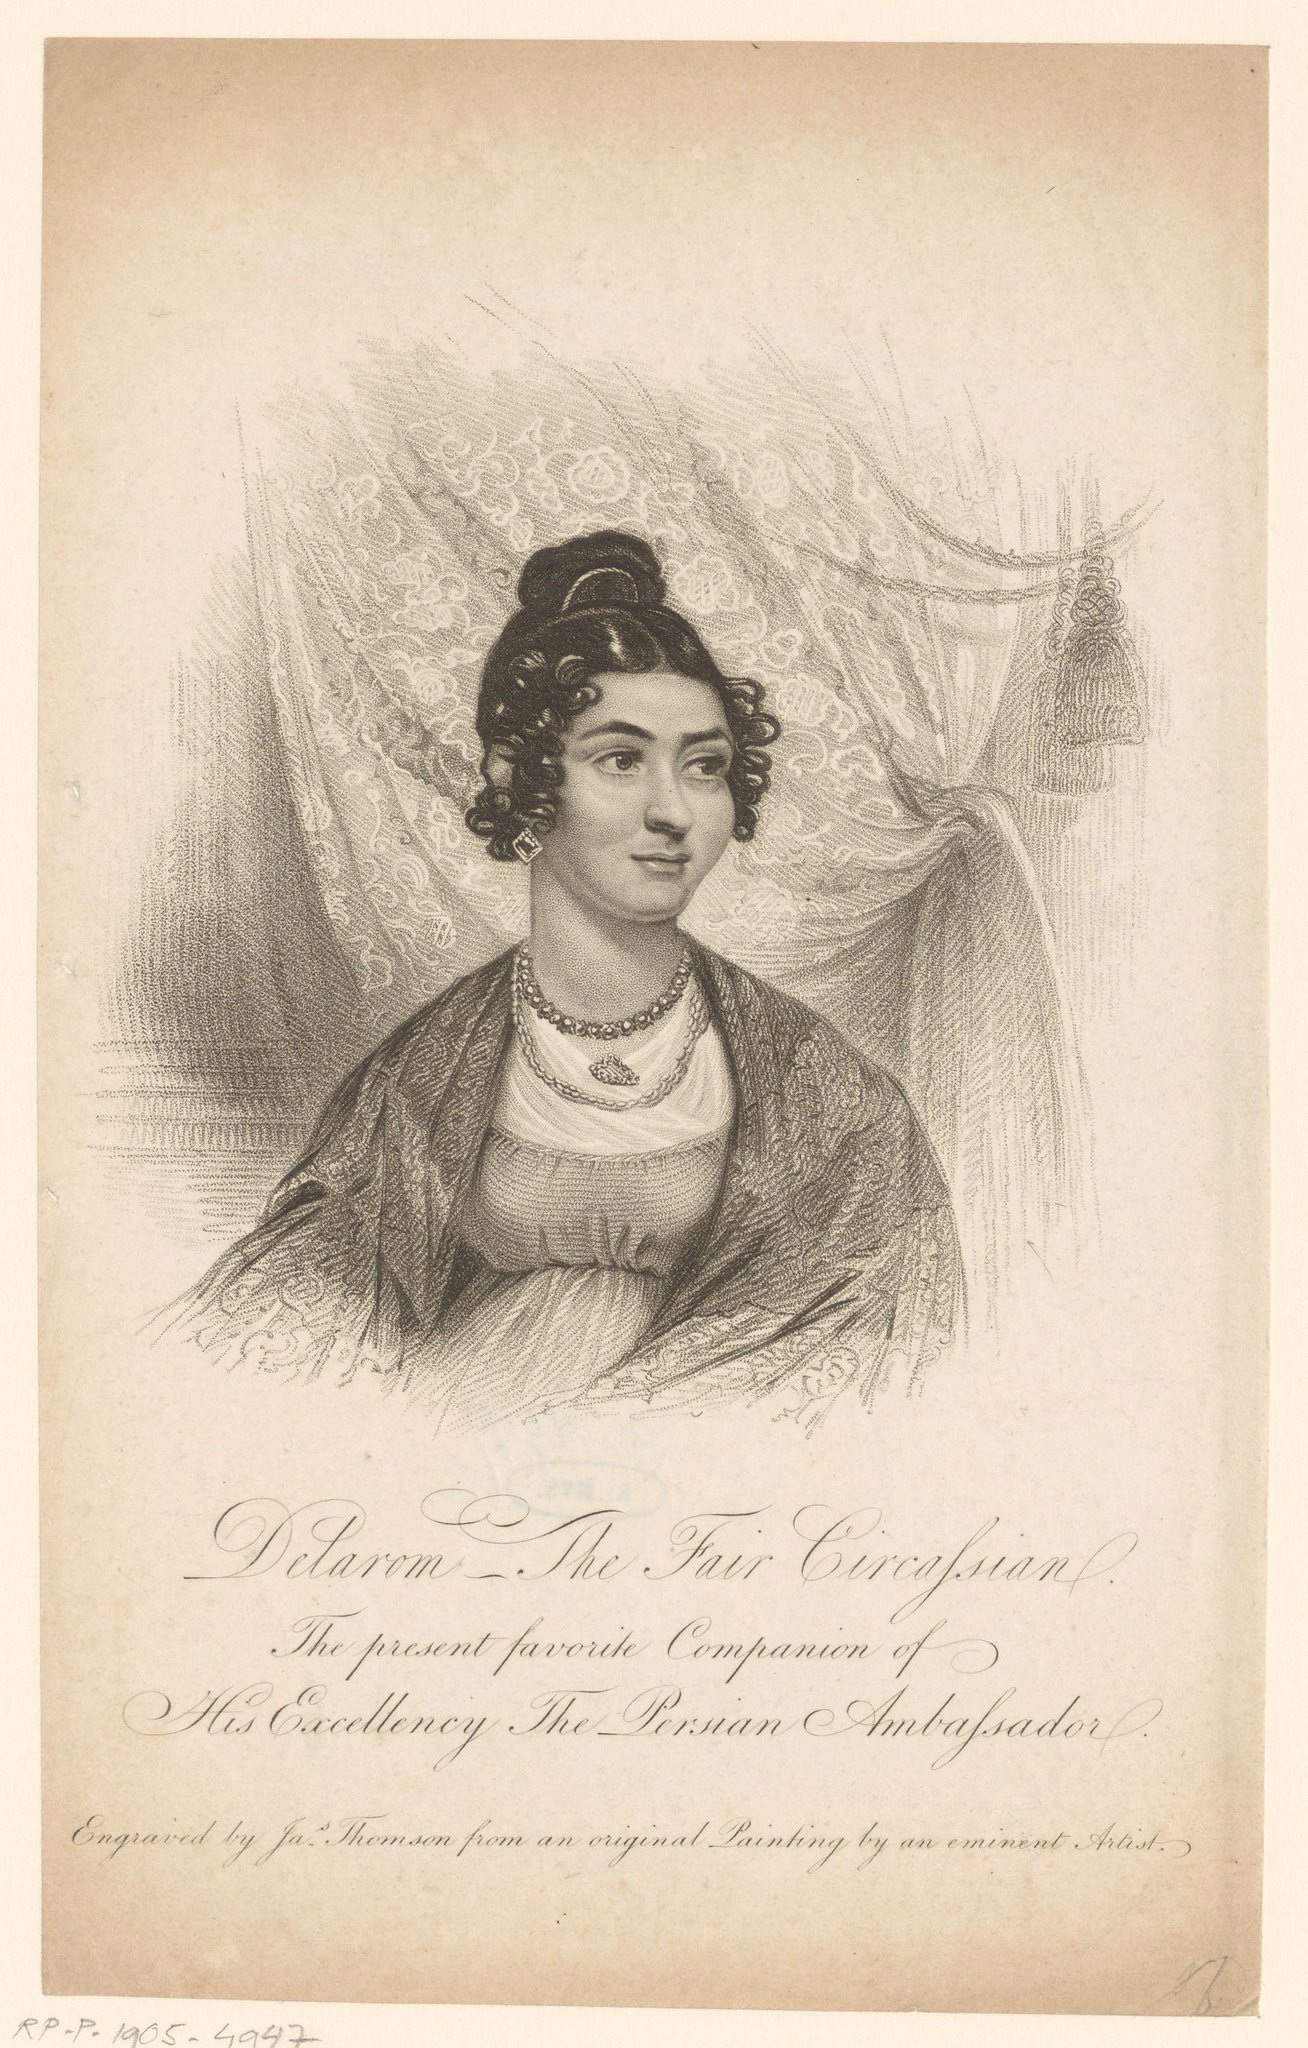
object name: print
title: Delarom The Fair Circassian (...)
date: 1819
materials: paper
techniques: roulette, engraving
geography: london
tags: historical persons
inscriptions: collector's mark: Lugt 2228